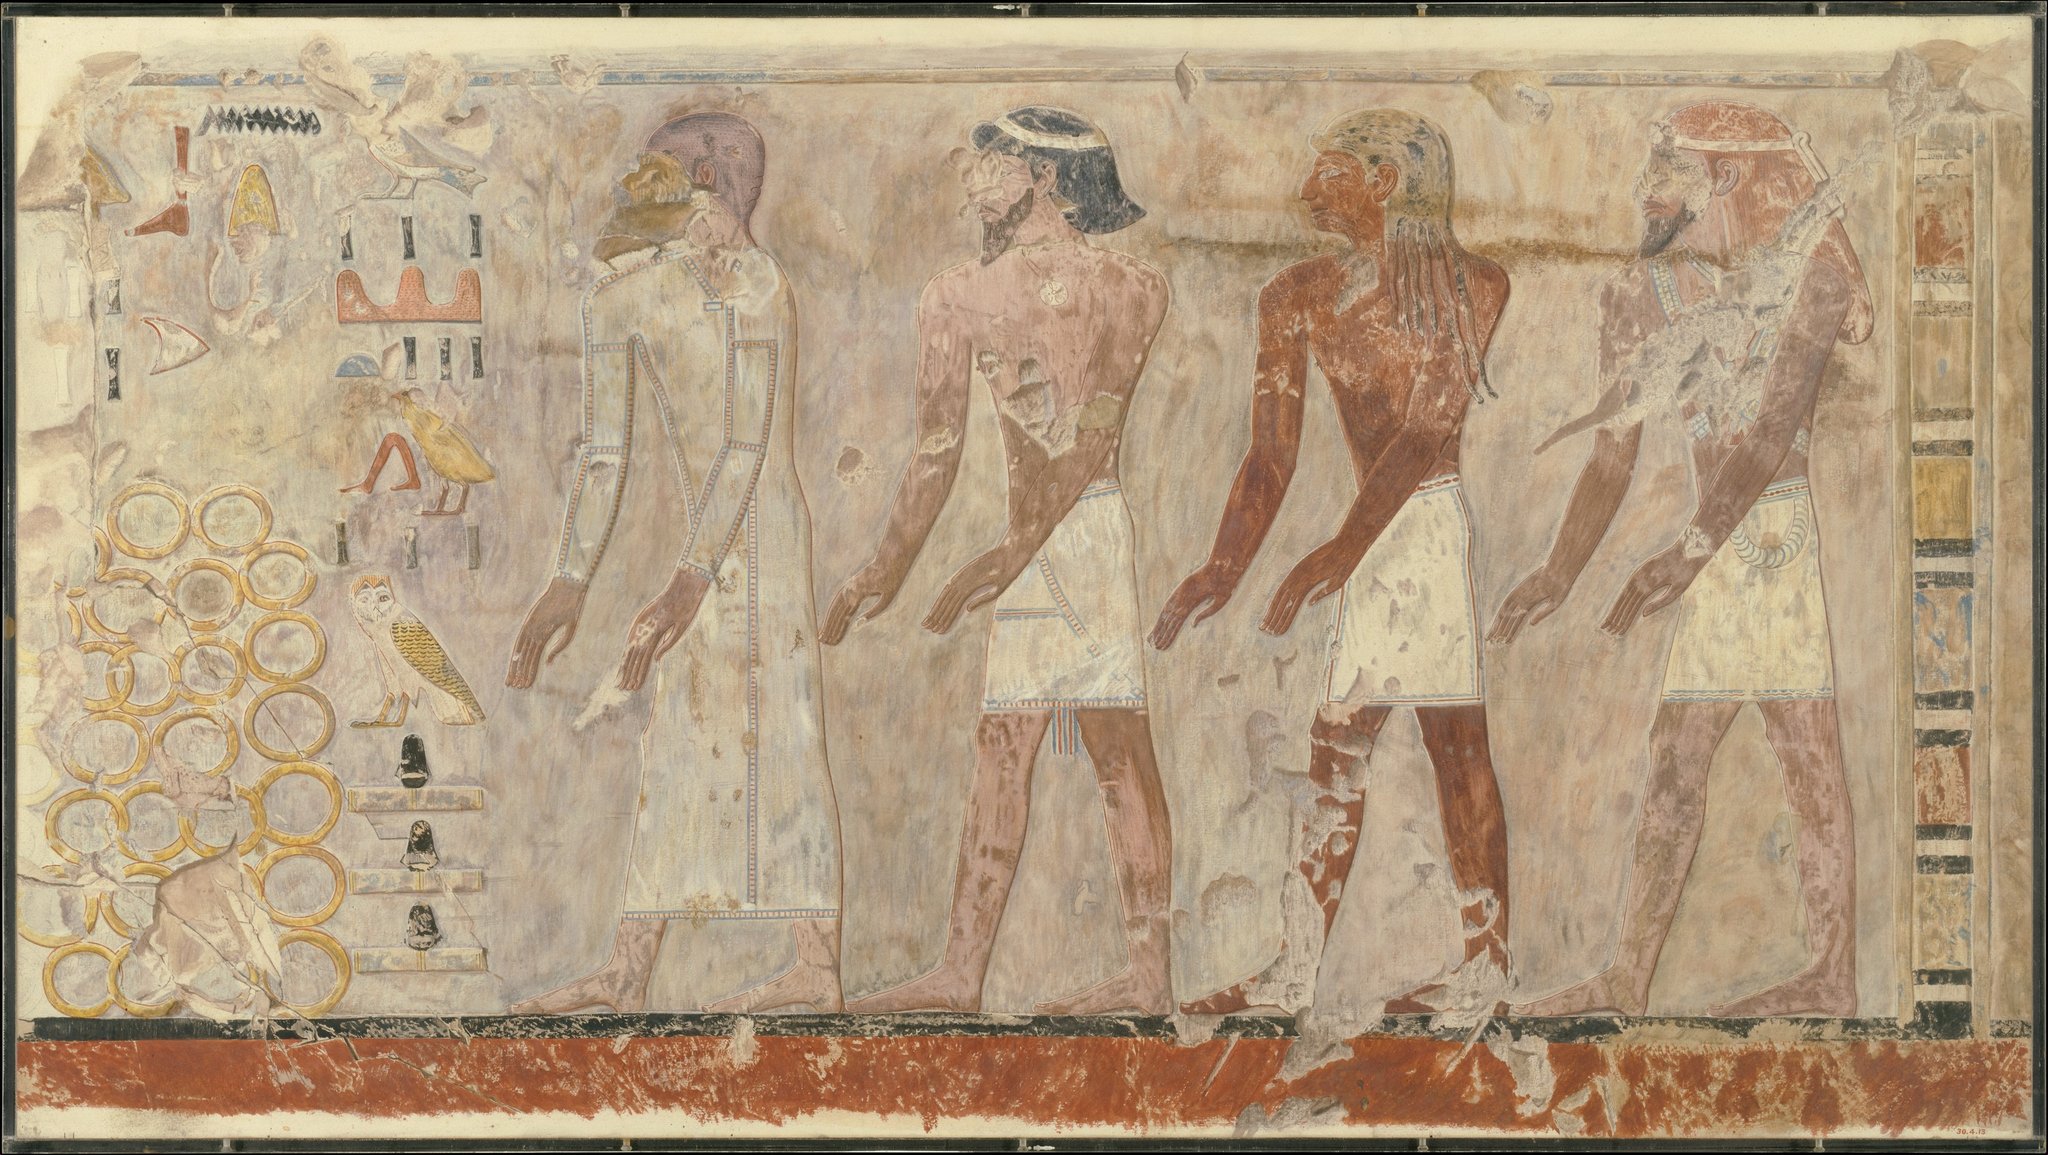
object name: facsimile, puyemre tt 39, foreigner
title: Four Foreign Rulers, Tomb of Puyemre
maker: norman de garis davies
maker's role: artist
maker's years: 1865-1941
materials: paper, paint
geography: egypt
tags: birds,men,hieroglyphs